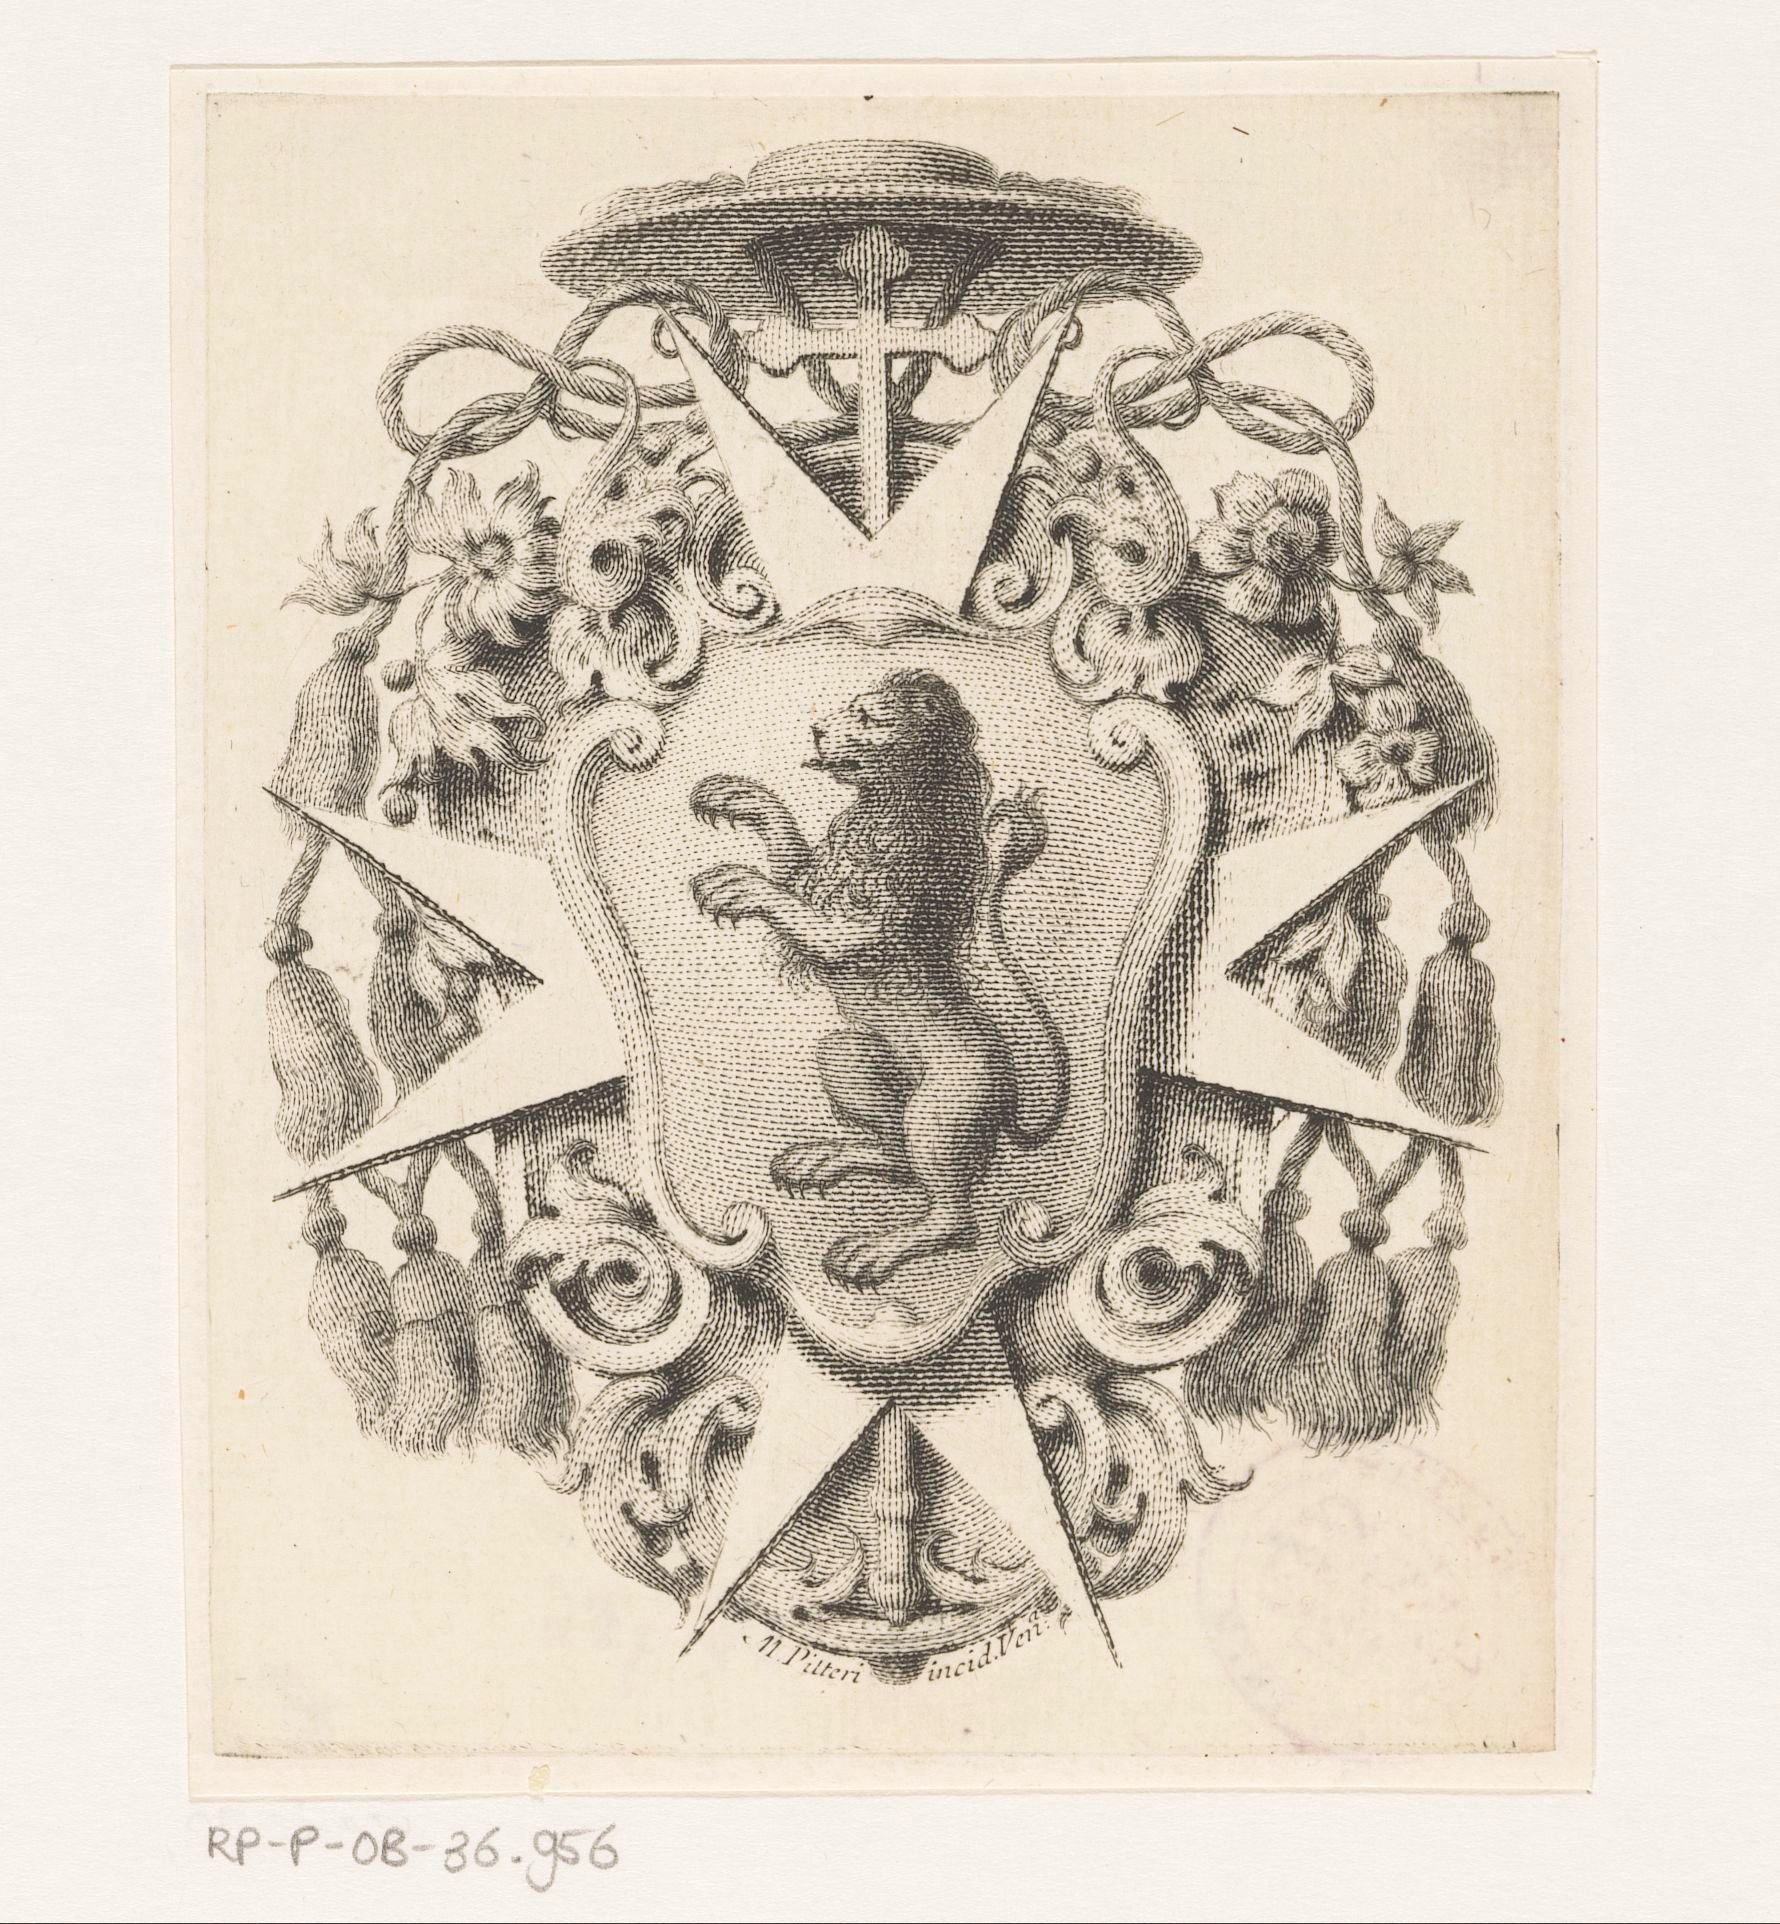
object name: print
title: Kardinaalswapen met leeuw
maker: giovanni marco pitteri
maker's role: print maker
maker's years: 1702-1786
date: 1718-1746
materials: paper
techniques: engraving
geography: venice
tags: bari, trani, coat of arms (symbol of sovereignty), cardinal, beasts of prey, predatory animals: lion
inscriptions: collector's mark: Lugt 240